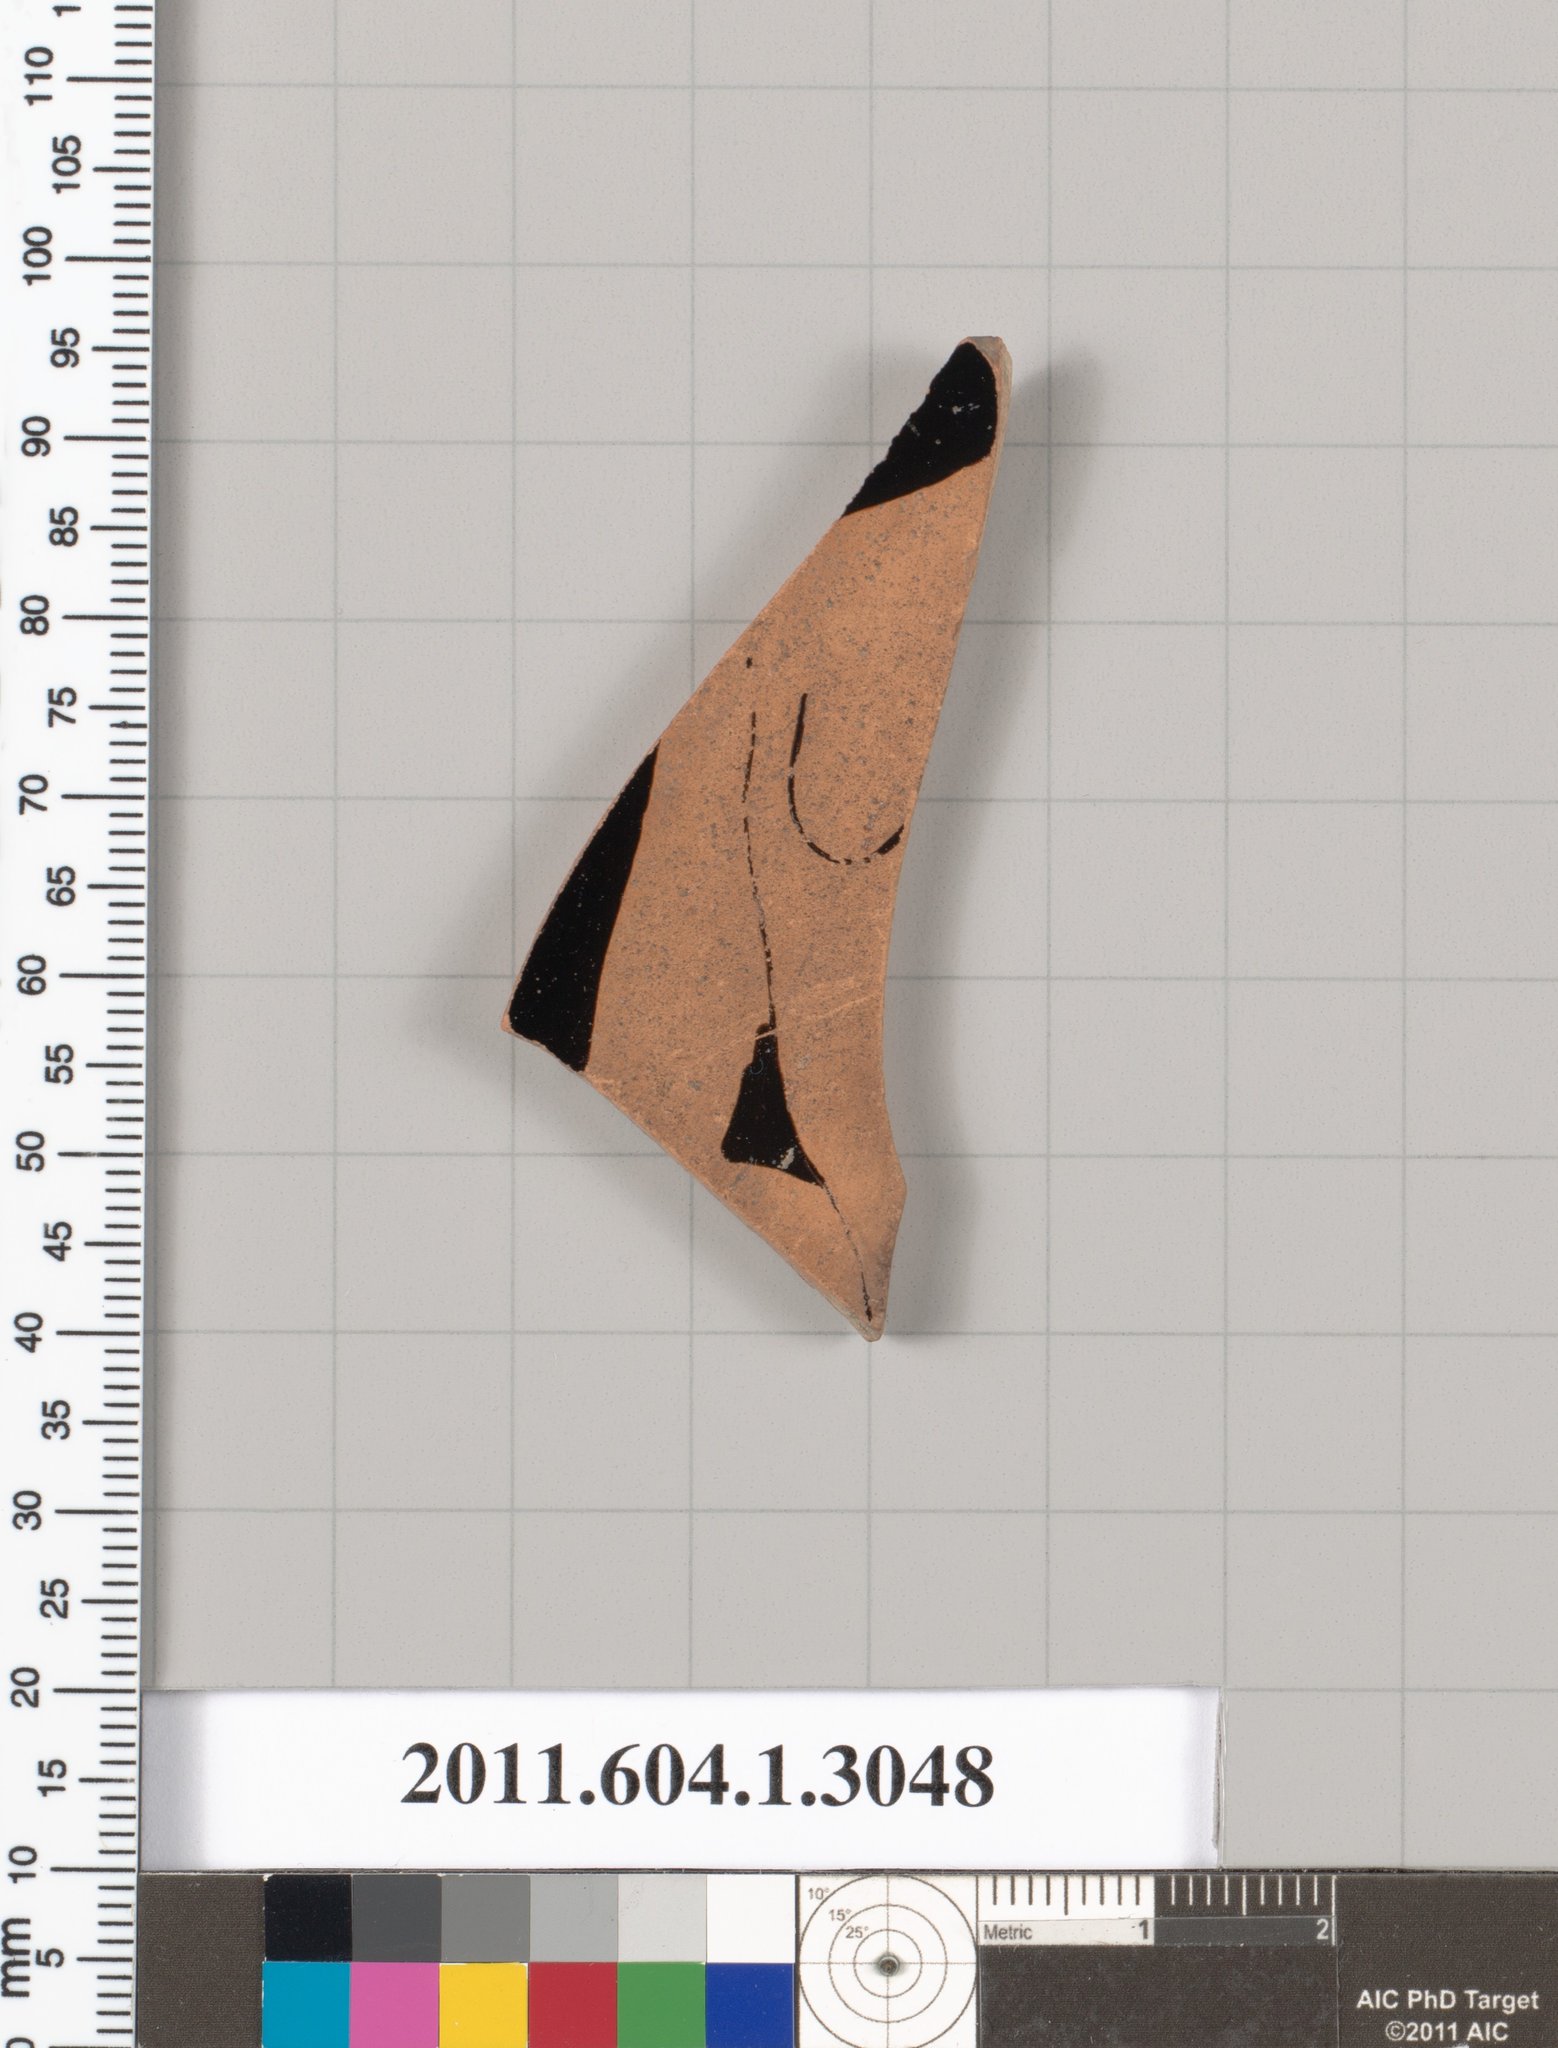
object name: kylix fragment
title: Terracotta fragment of a kylix (drinking cup)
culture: greek, attic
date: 475-451 BCE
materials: terracotta